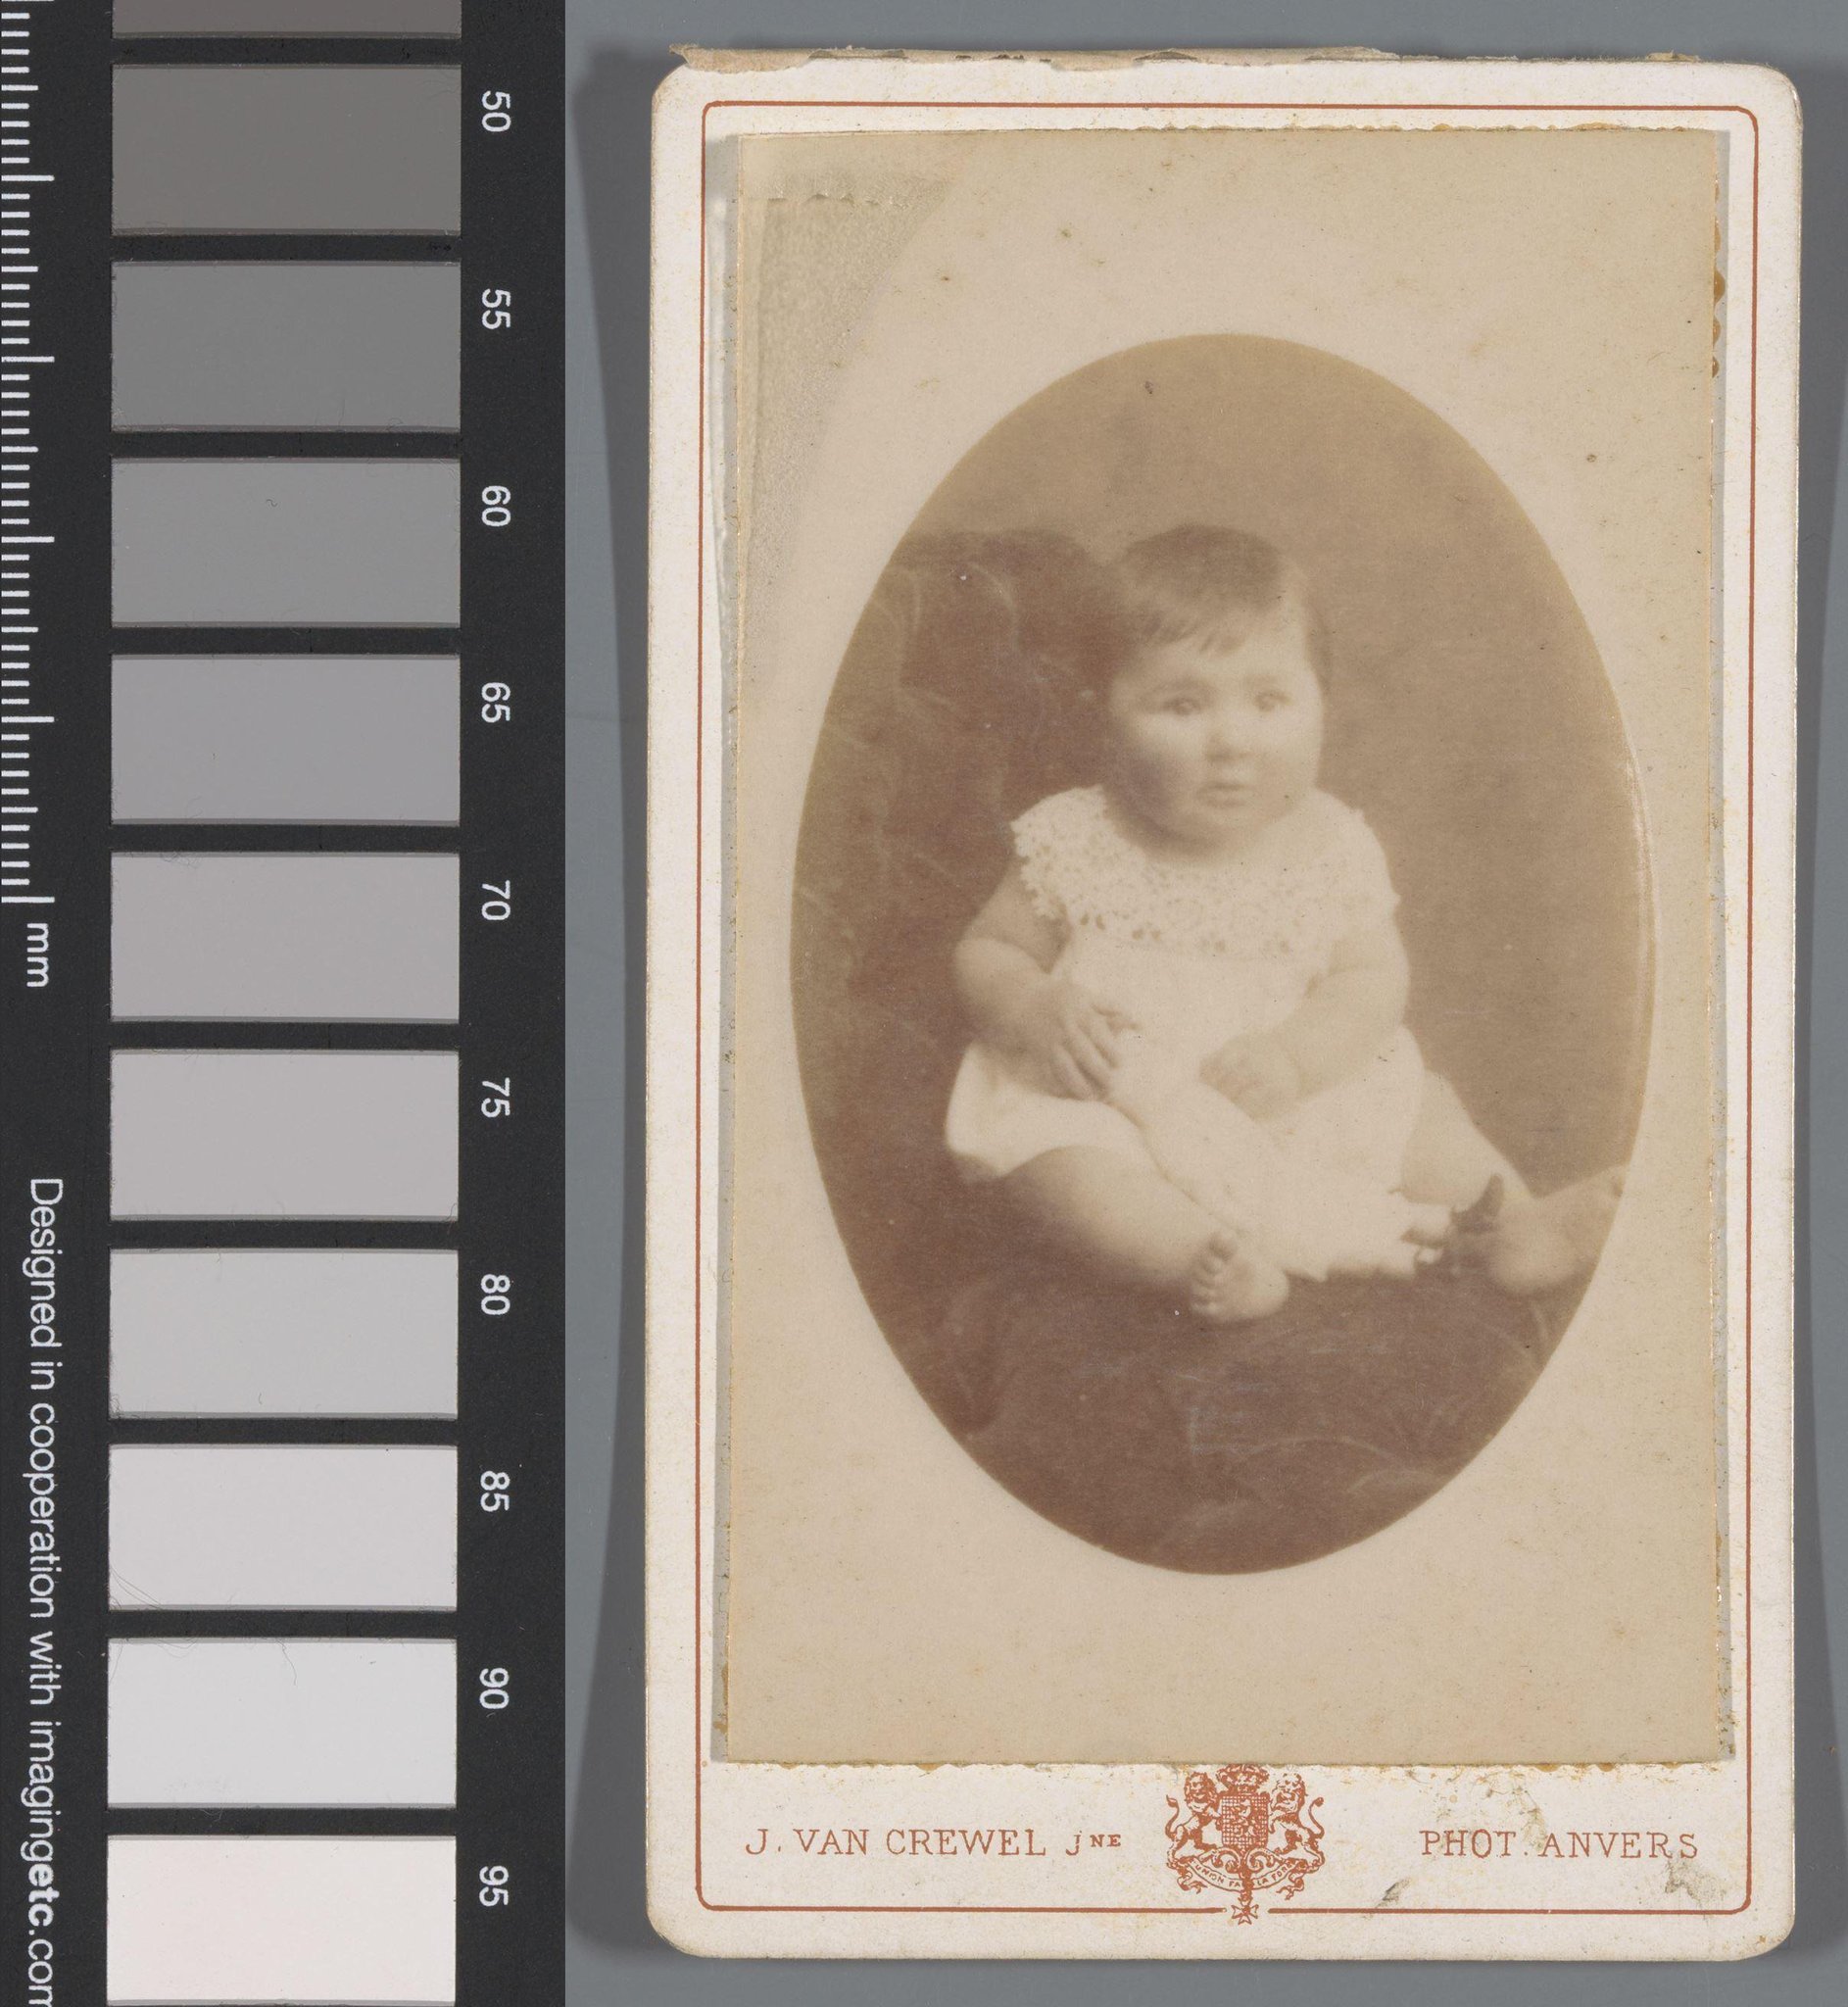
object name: carte de visite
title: Portret van een onbekende baby op een fauteuil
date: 1885-1900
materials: cardboard, celluloid, paper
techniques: albumen print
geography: antwerp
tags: child, anonymous historical person portrayed, antwerp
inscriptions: inscription: ‘Brévet d'/ Invention/ Médaille d'argent/ a l'Exposition Rubens 1881/ obtenue pour le procédé instantané/ J. van Crewel Jeune/ Photographe bréveté/ 48. rue du Pélican, 48/ en face de la Gare/ Anvers/ Galerie de Pose dans le Jardin./ D. Hutinet Paris’, inscription: ‘J. van Crewel Jne Phot. Anvers’